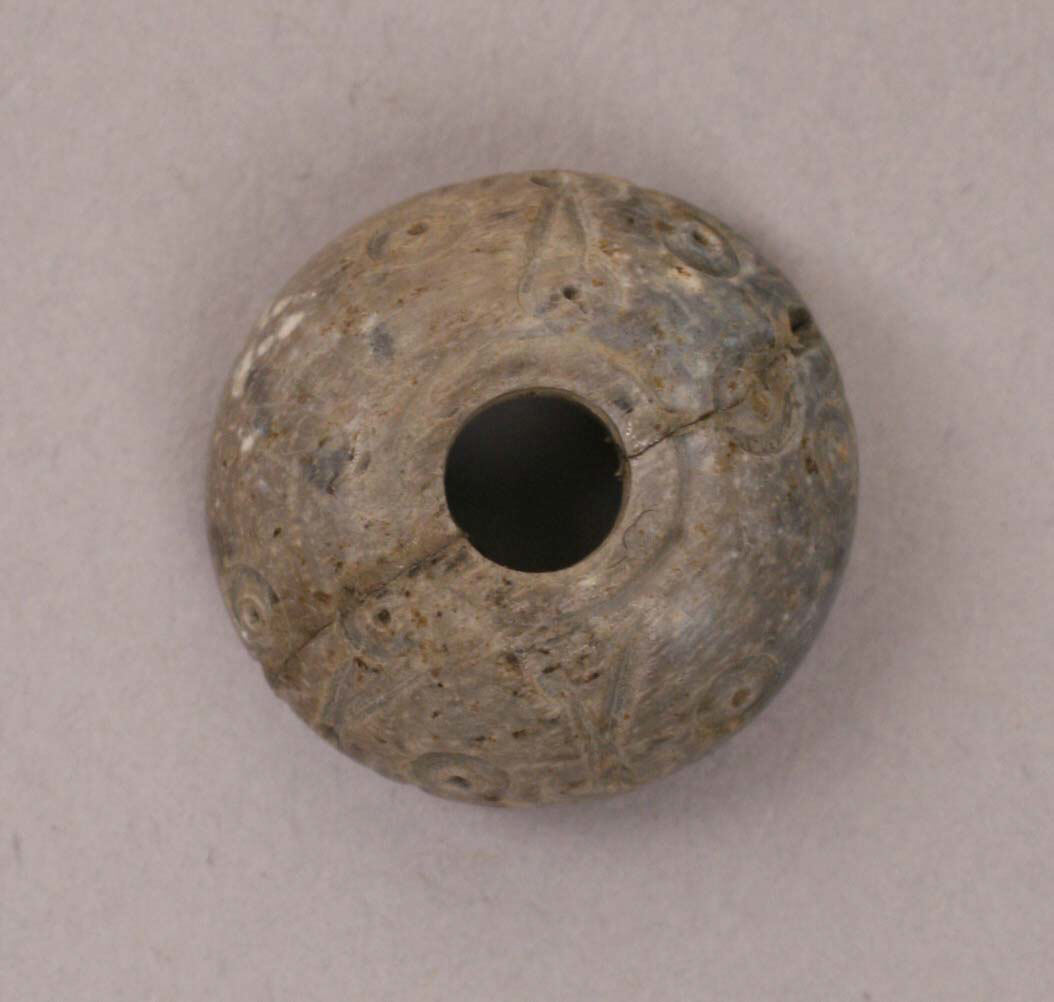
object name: button or bead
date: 801-1000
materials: bone, paint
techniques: incising, inlay, tinting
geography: iran